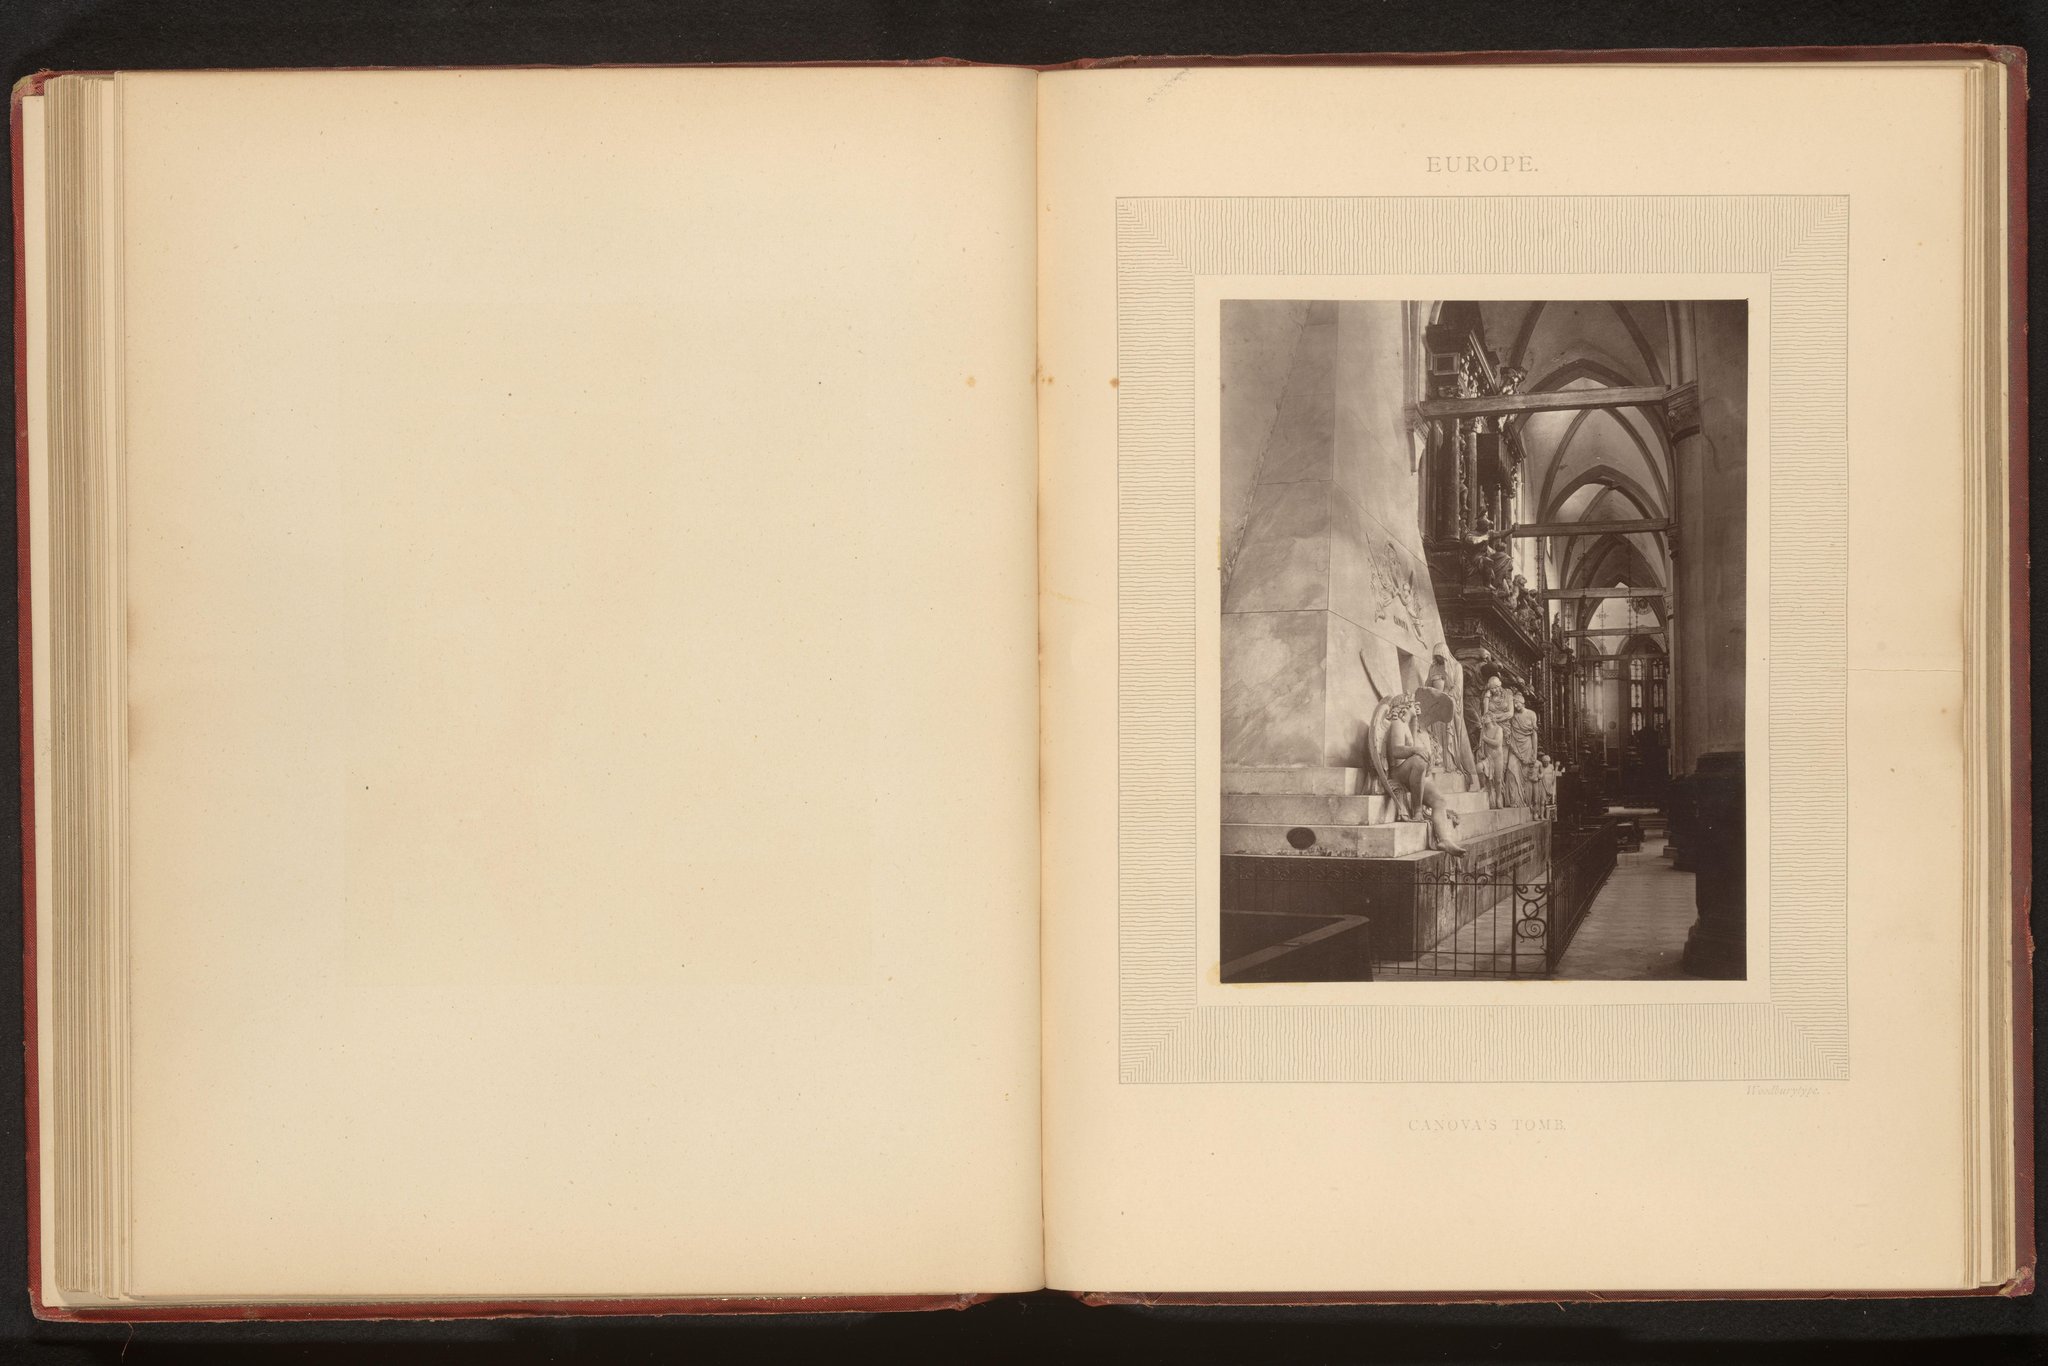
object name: photomechanical print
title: Grafmonument van Antonio Canova in de Basilica di Santa Maria Gloriosa dei Frari te Venetië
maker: carlo naya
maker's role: fotograaf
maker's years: 1816-1882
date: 1870-1875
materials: cardboard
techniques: woodburytype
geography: basilica di santa maria gloriosa dei frari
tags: painter, draughtsman, sculptor, antonio canova, grave-building, monumental tomb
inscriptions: inscription: ‘Europe’